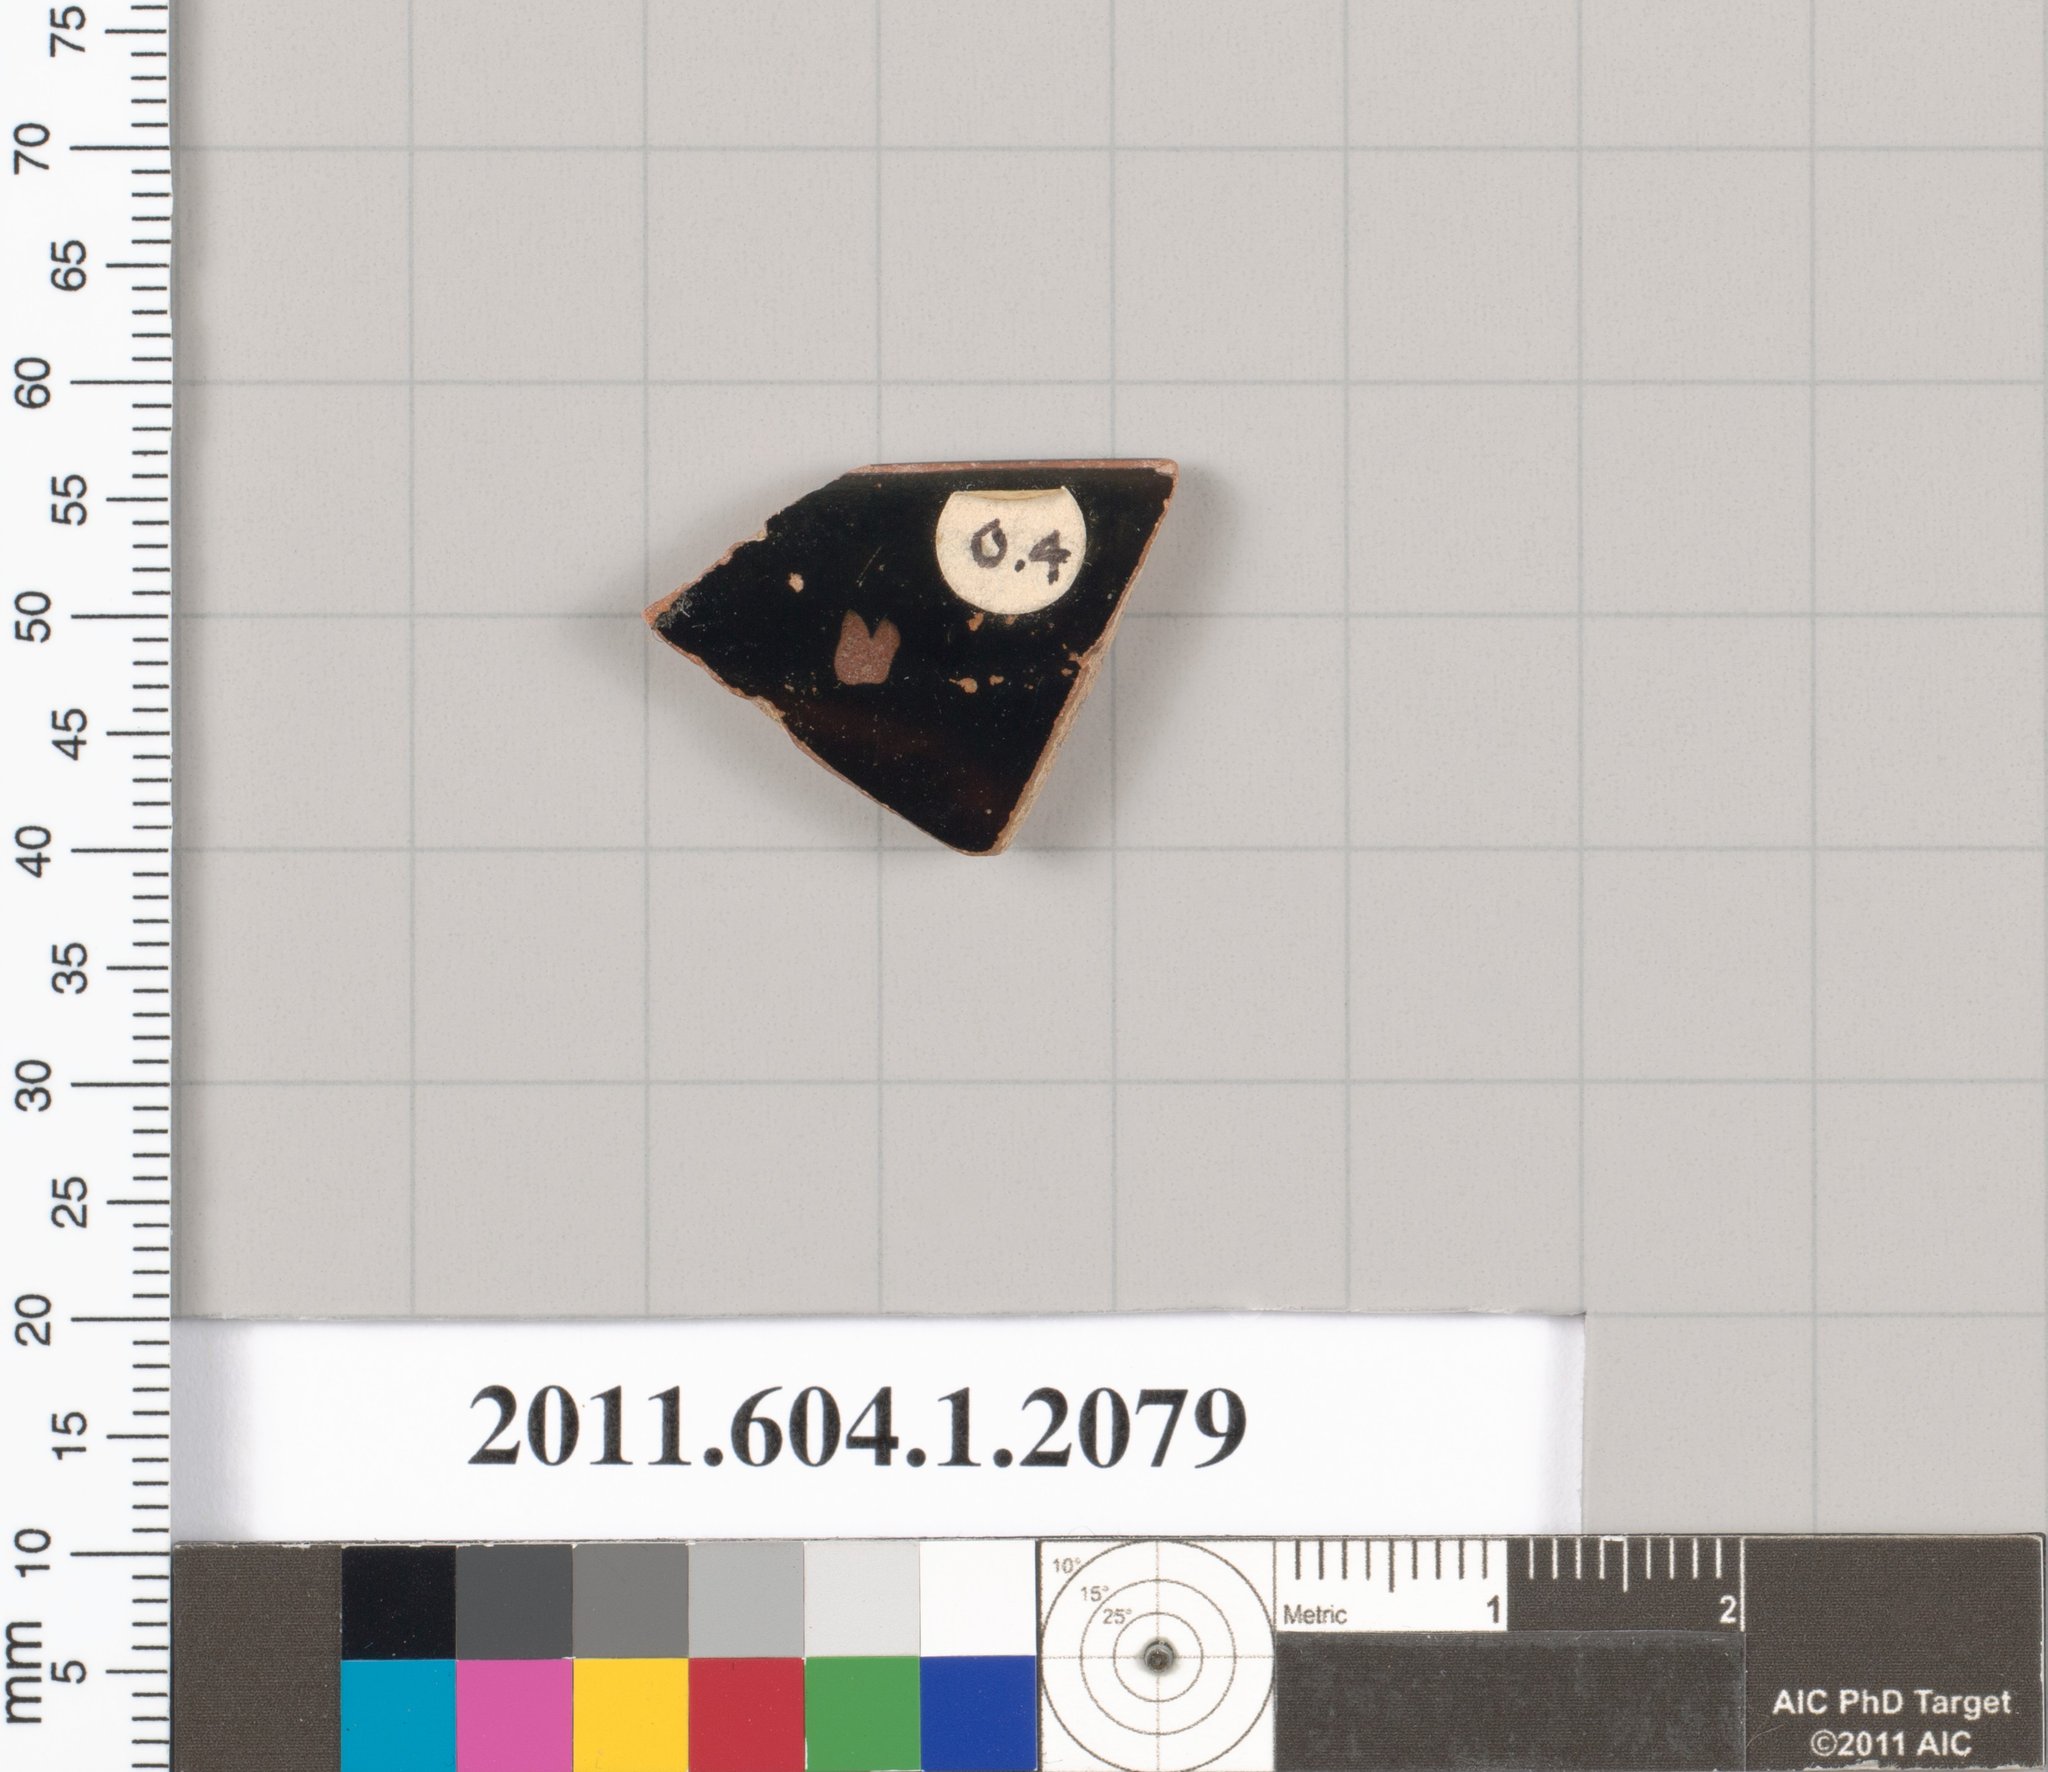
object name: kylix fragment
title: Terracotta rim fragment of a kylix (drinking cup)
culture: greek, attic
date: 500-401 BCE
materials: terracotta